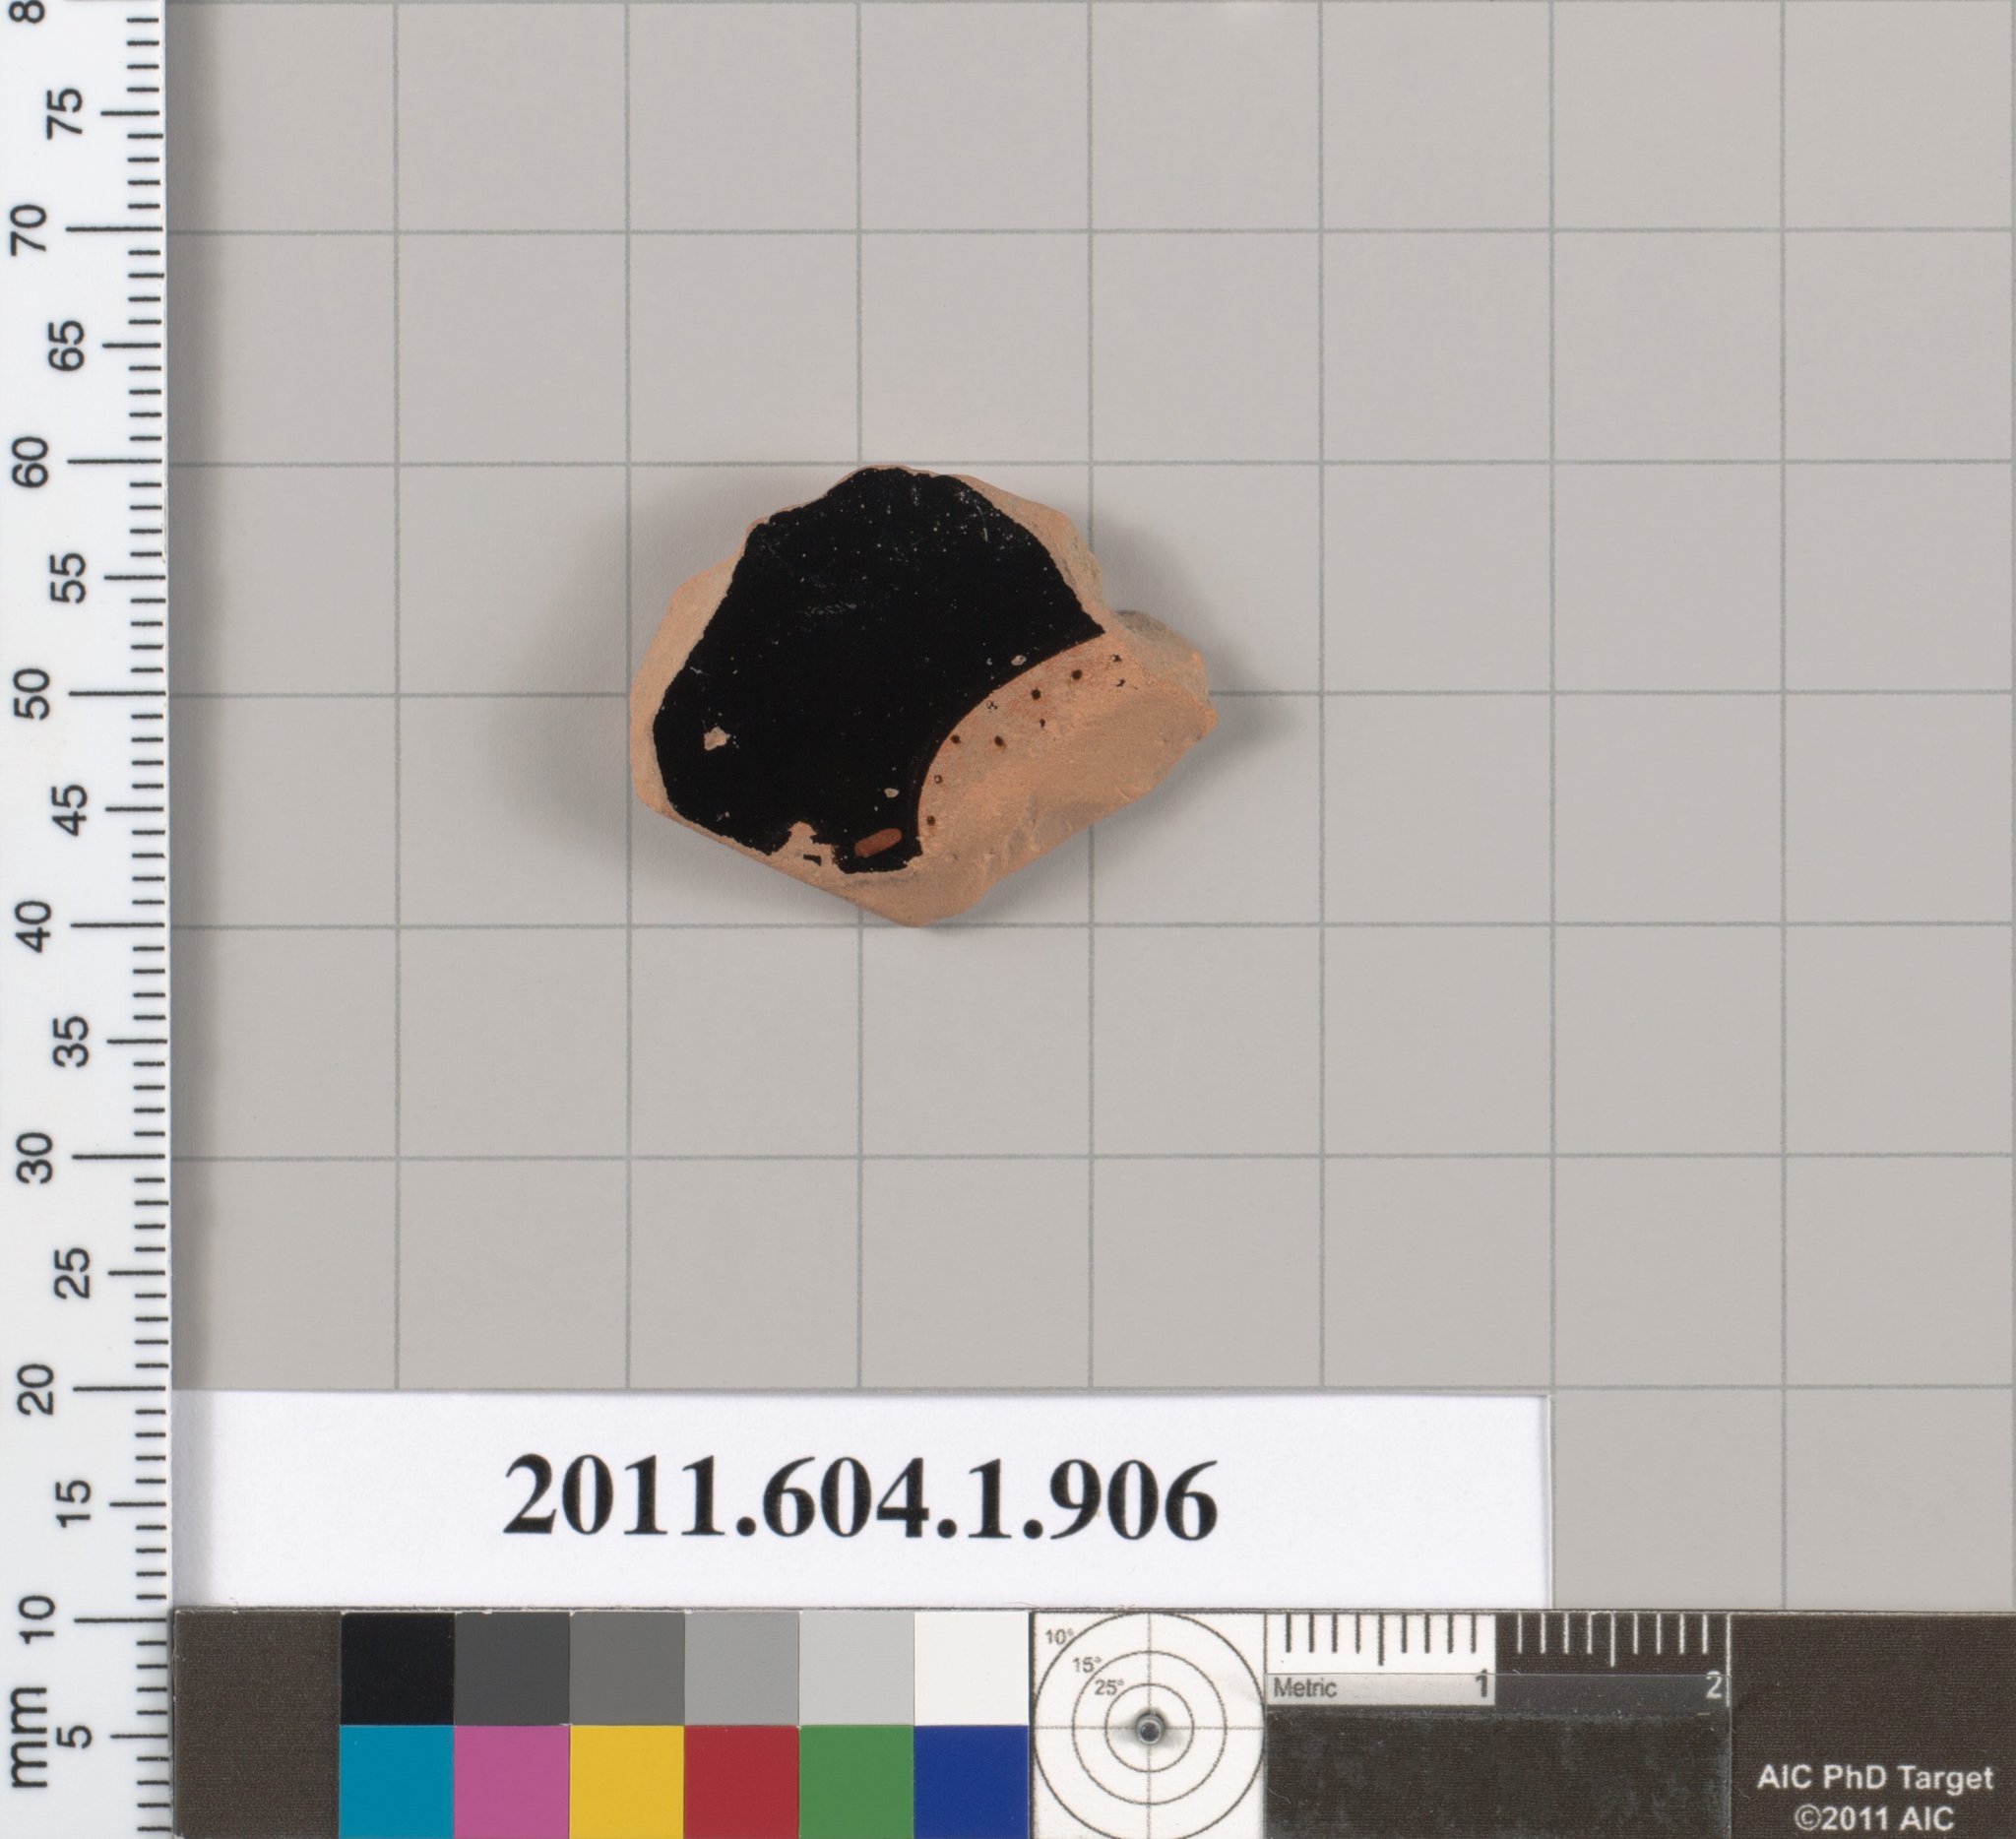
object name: kylix fragment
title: Terracotta fragment of a kylix (drinking cup)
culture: greek, attic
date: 475-451 BCE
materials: terracotta